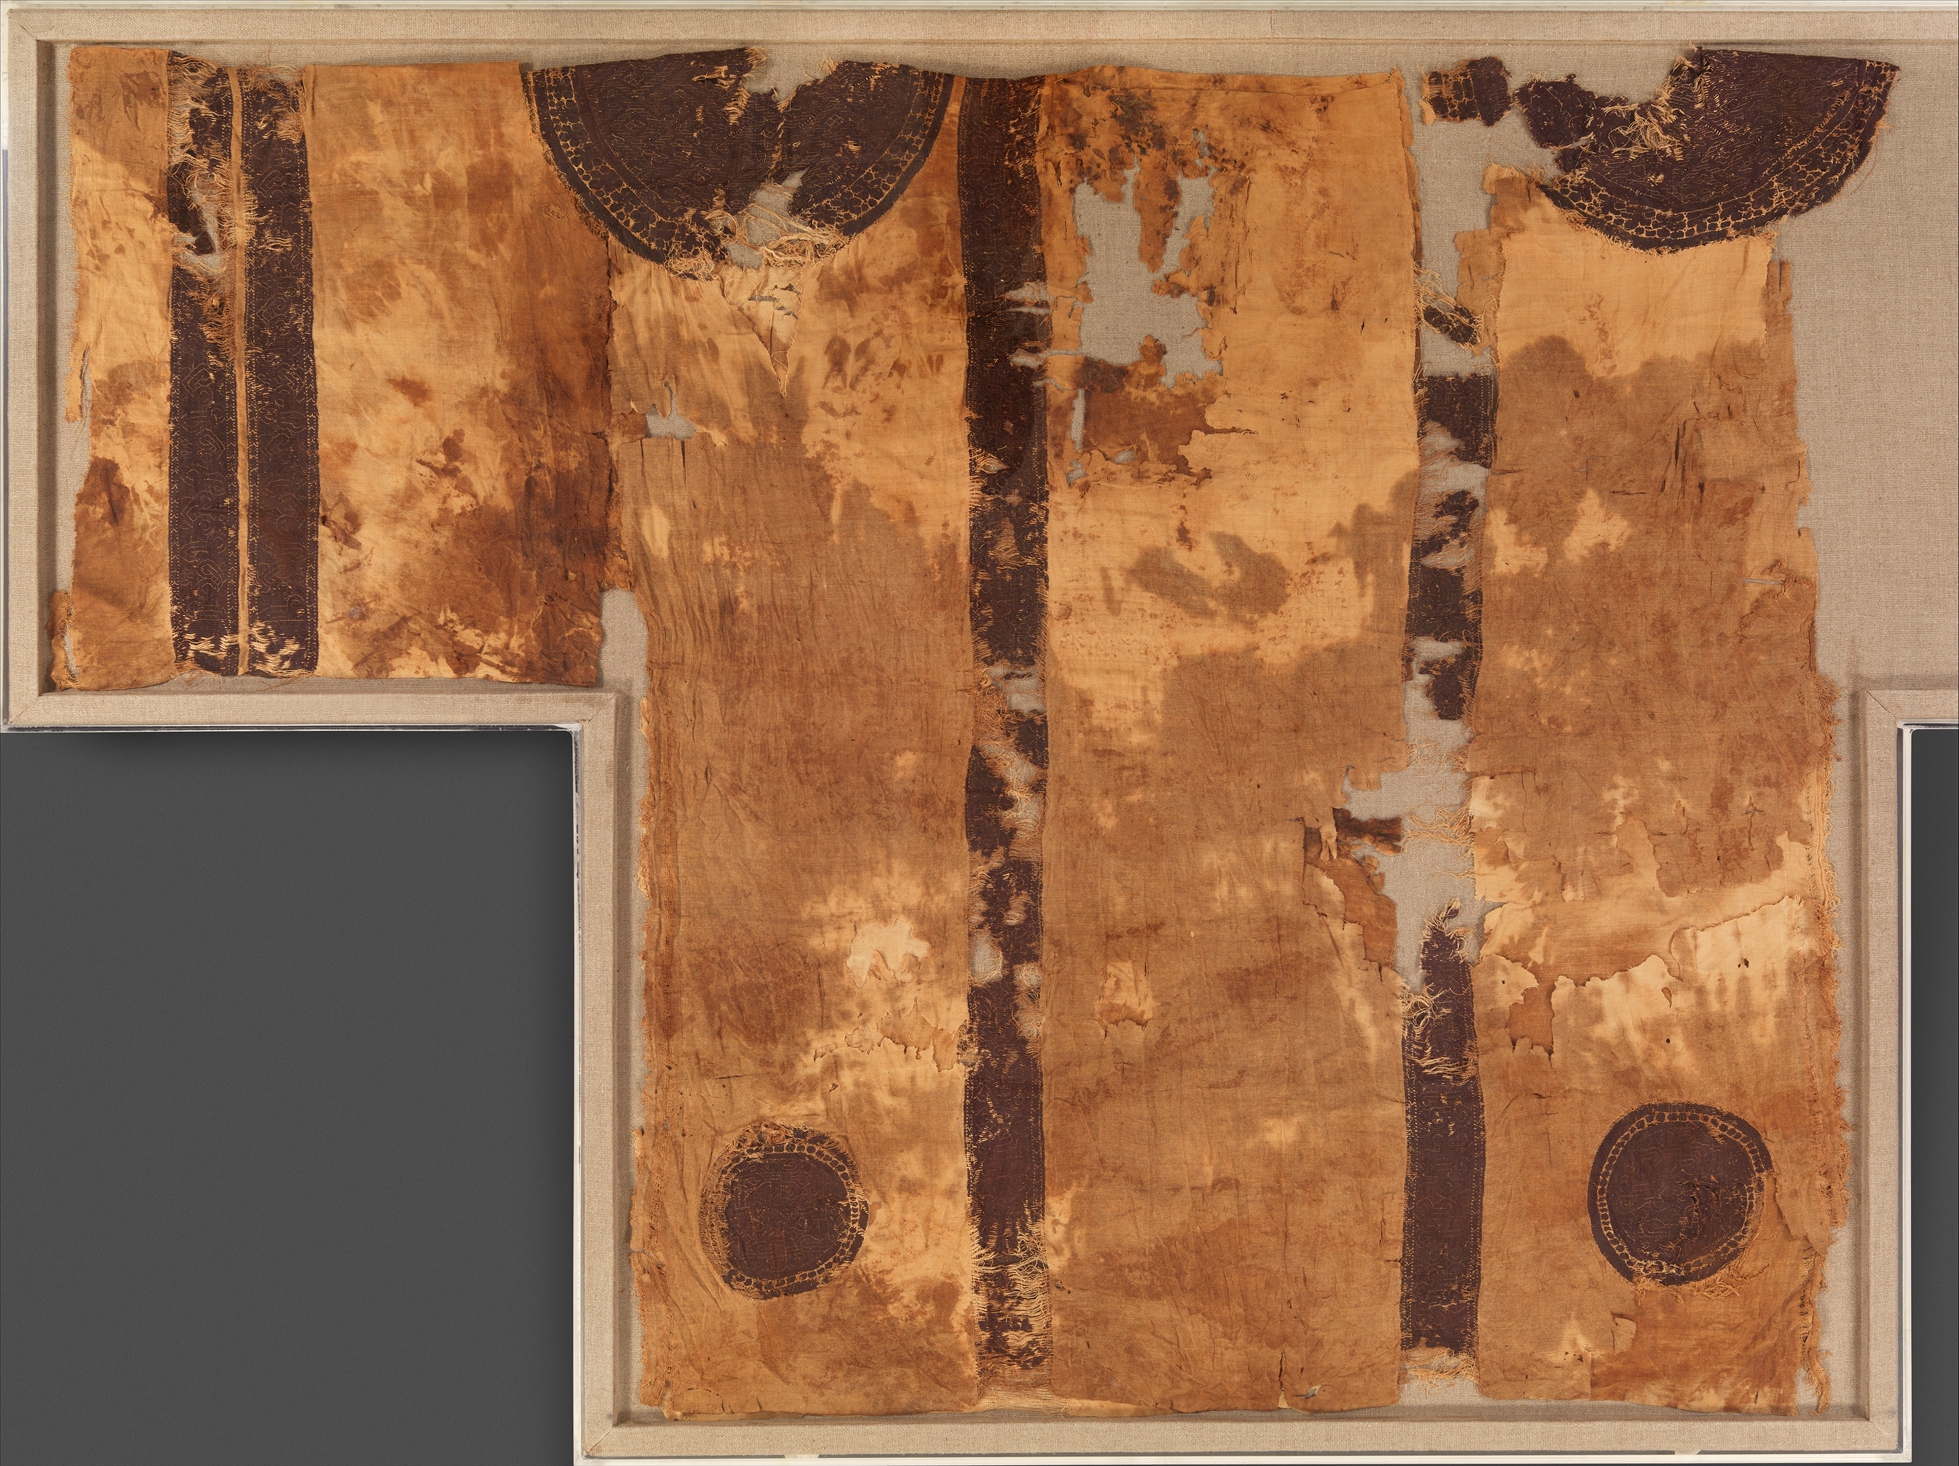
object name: fragment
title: Dress Fragment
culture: coptic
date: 301-400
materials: linen, wool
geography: egypt